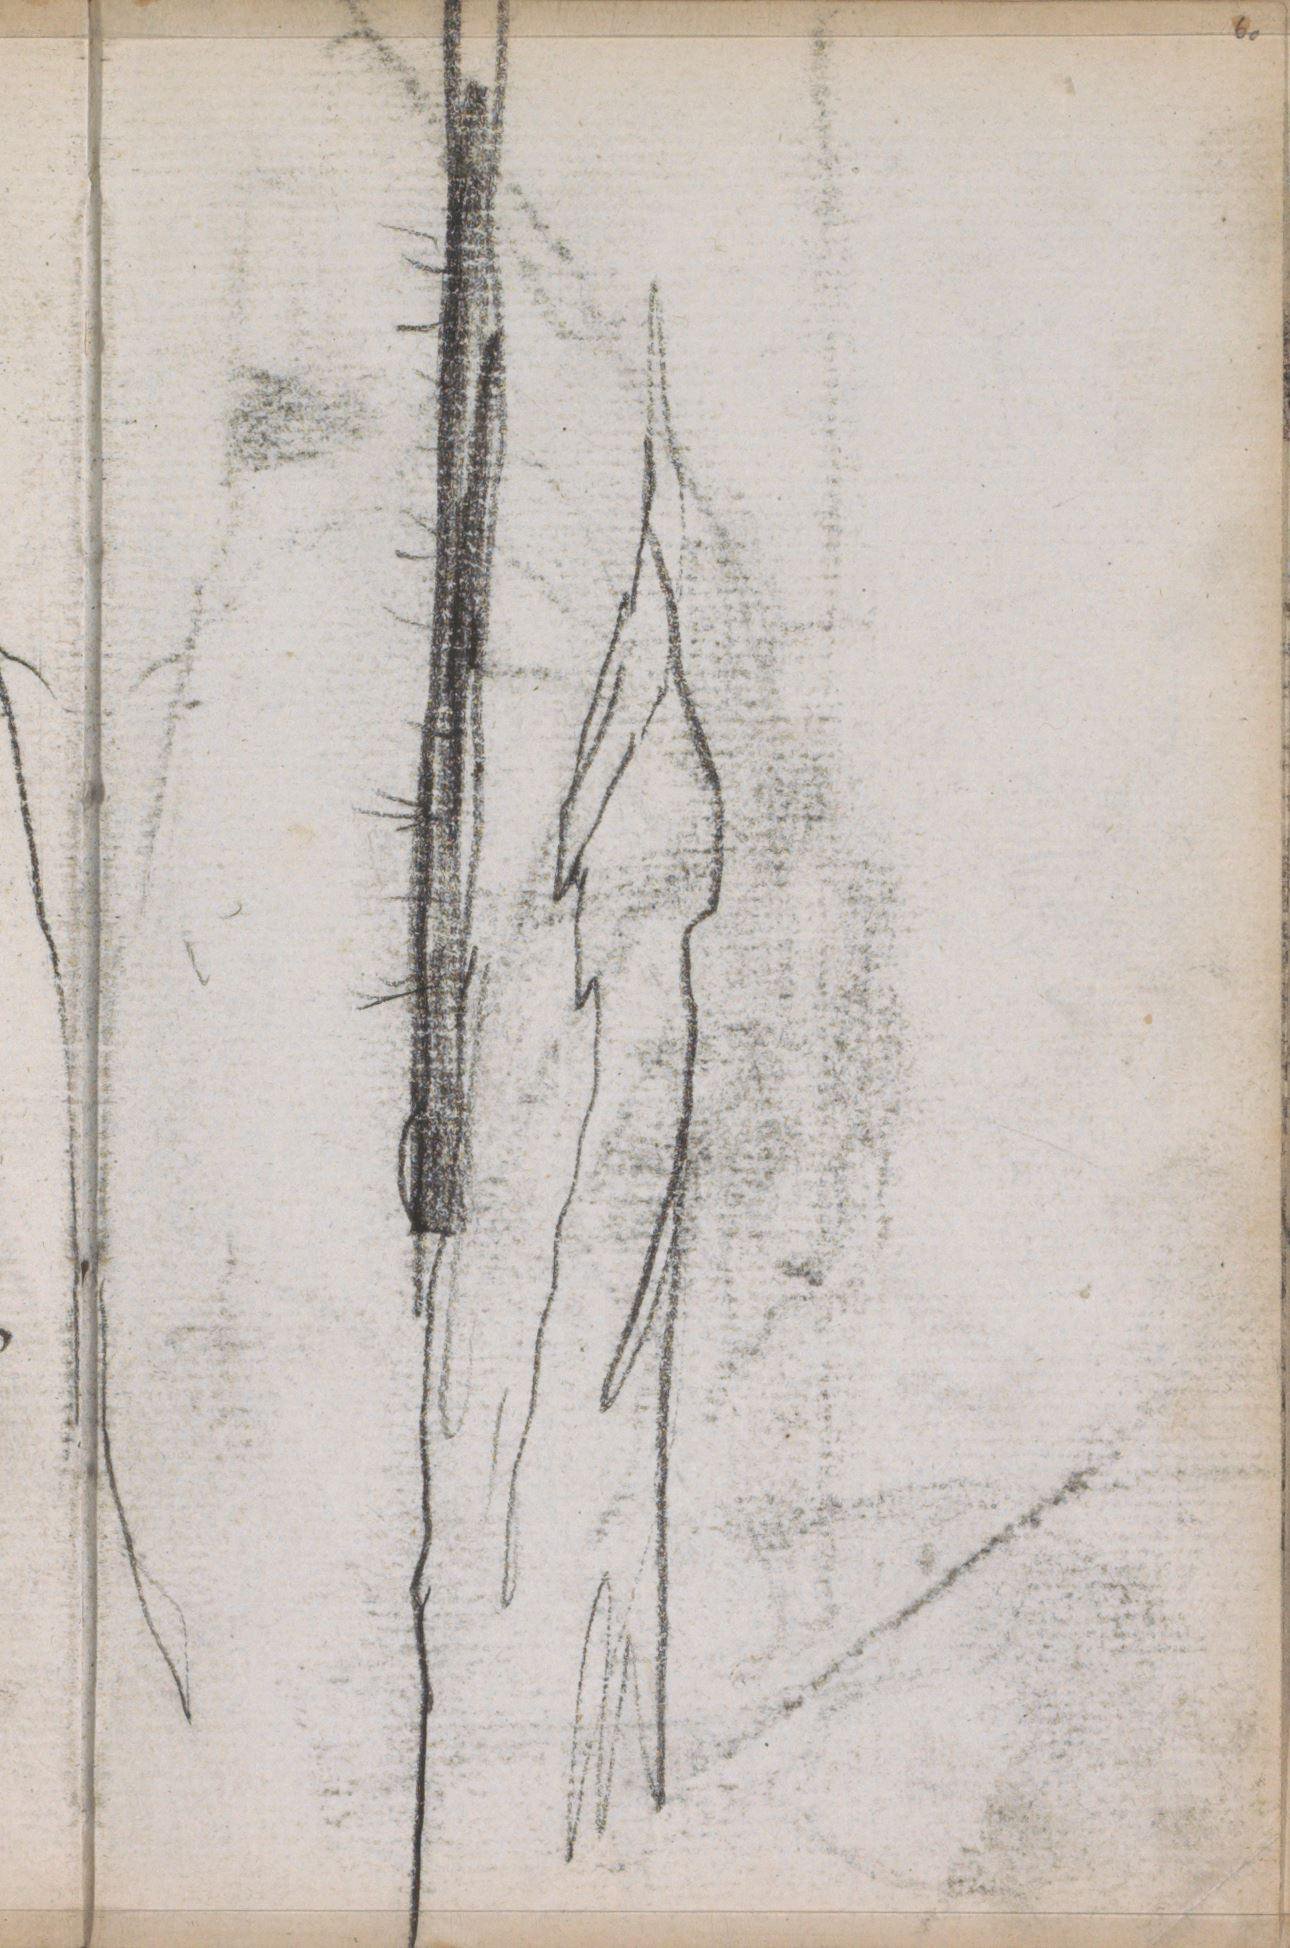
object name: sketchbook leaf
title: Landschap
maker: george hendrik breitner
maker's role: draughtsman, painter, print maker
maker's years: 1857-1923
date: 1884-1886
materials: chalk, paper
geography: drenthe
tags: landscapes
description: Pagina 60 uit een schetsboek met 67 bladen vervaardigd in Drenthe.